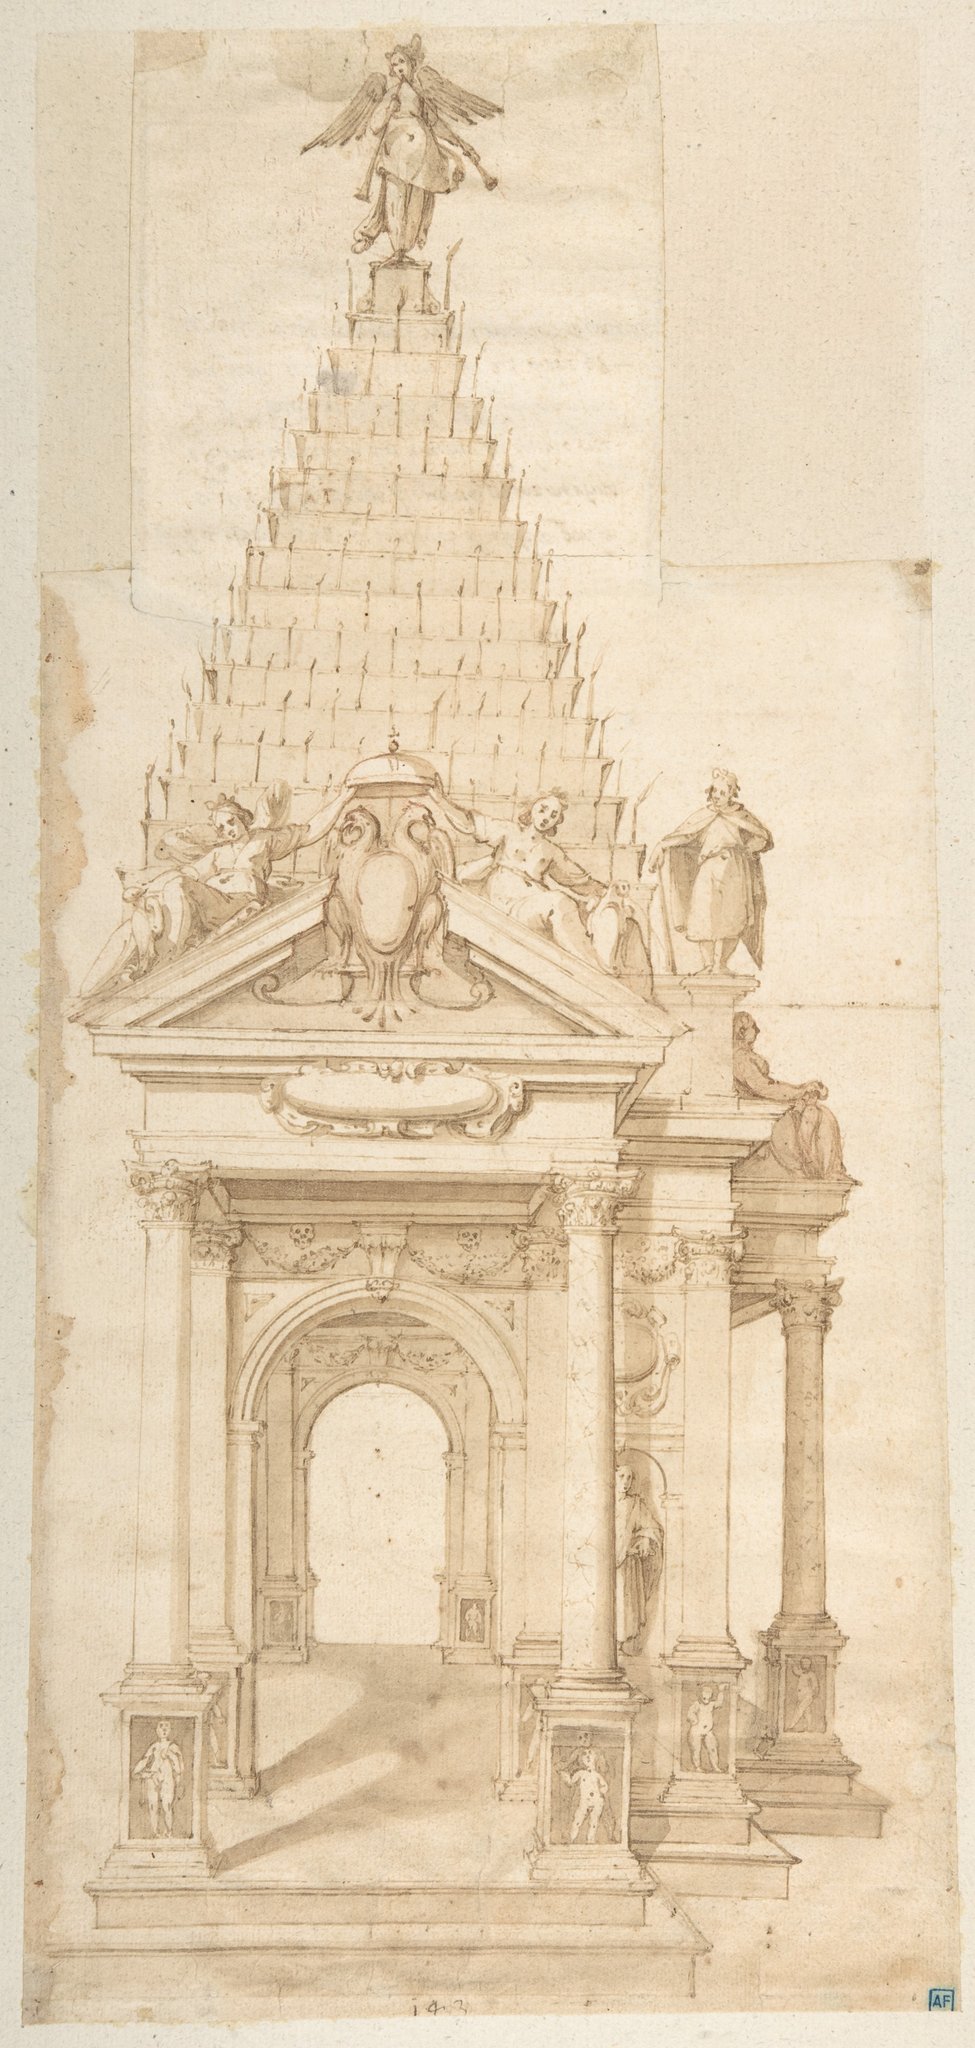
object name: drawing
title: Drawing of a Catafalque for Philip II of Spain, 1598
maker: alessandro casolani della torre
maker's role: artist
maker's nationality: italian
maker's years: 1552-1606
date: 1598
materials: ink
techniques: brush, pen, wash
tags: architecture